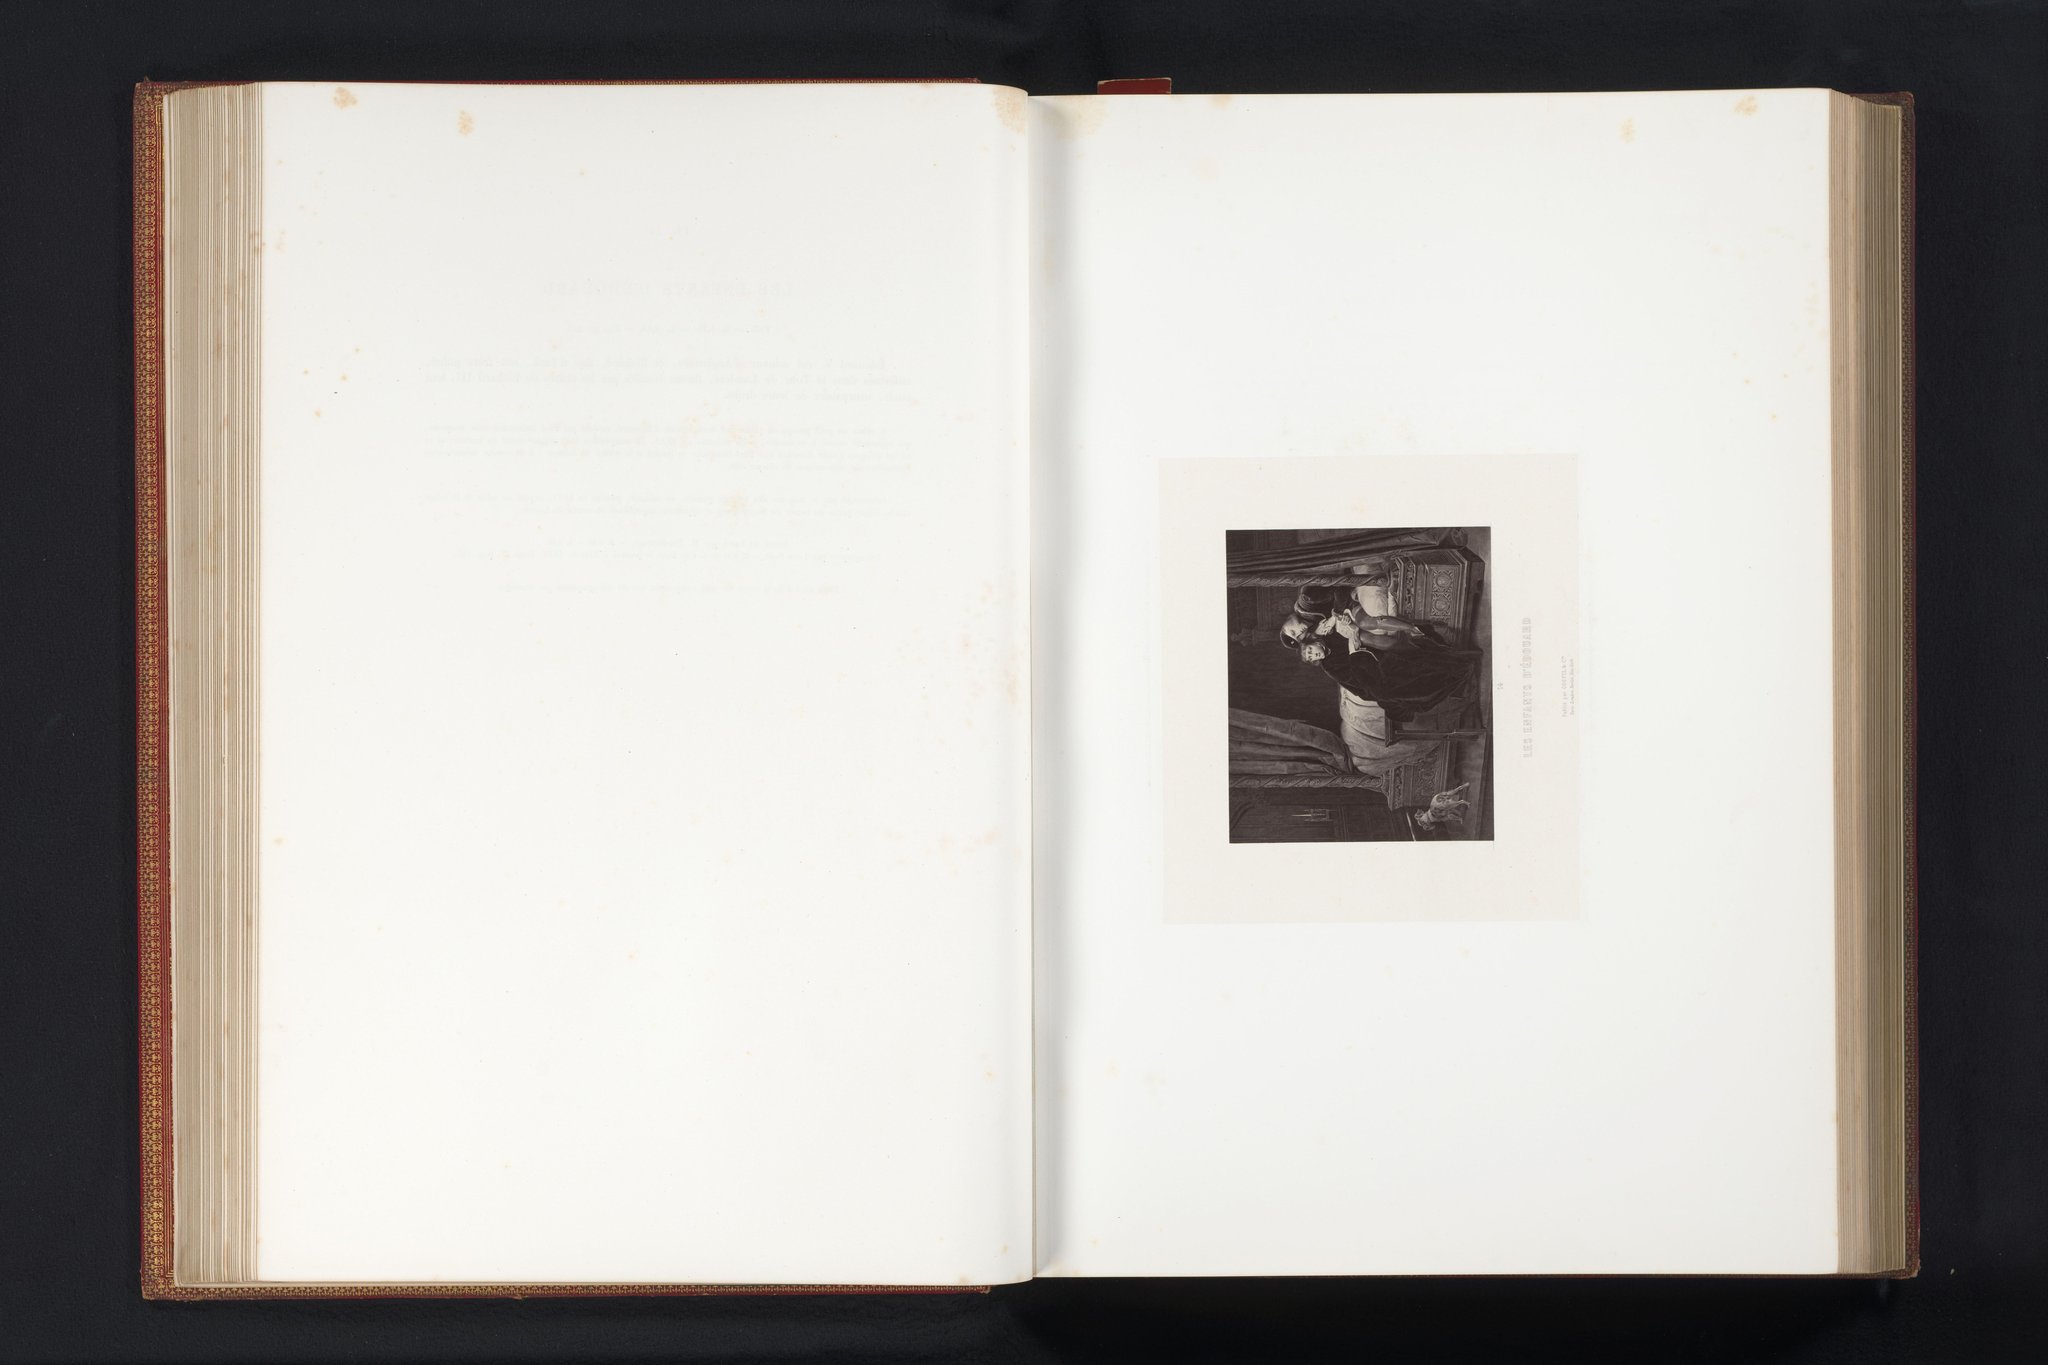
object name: photograph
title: Les enfants d'Édouard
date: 1853-1858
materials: paper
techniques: albumen print, engraving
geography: paris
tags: westminster abbey, london, edward v, boy (child between toddler and youth), prisoner in cell or locked place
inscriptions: check stamp: ‘Goupil & Cie’